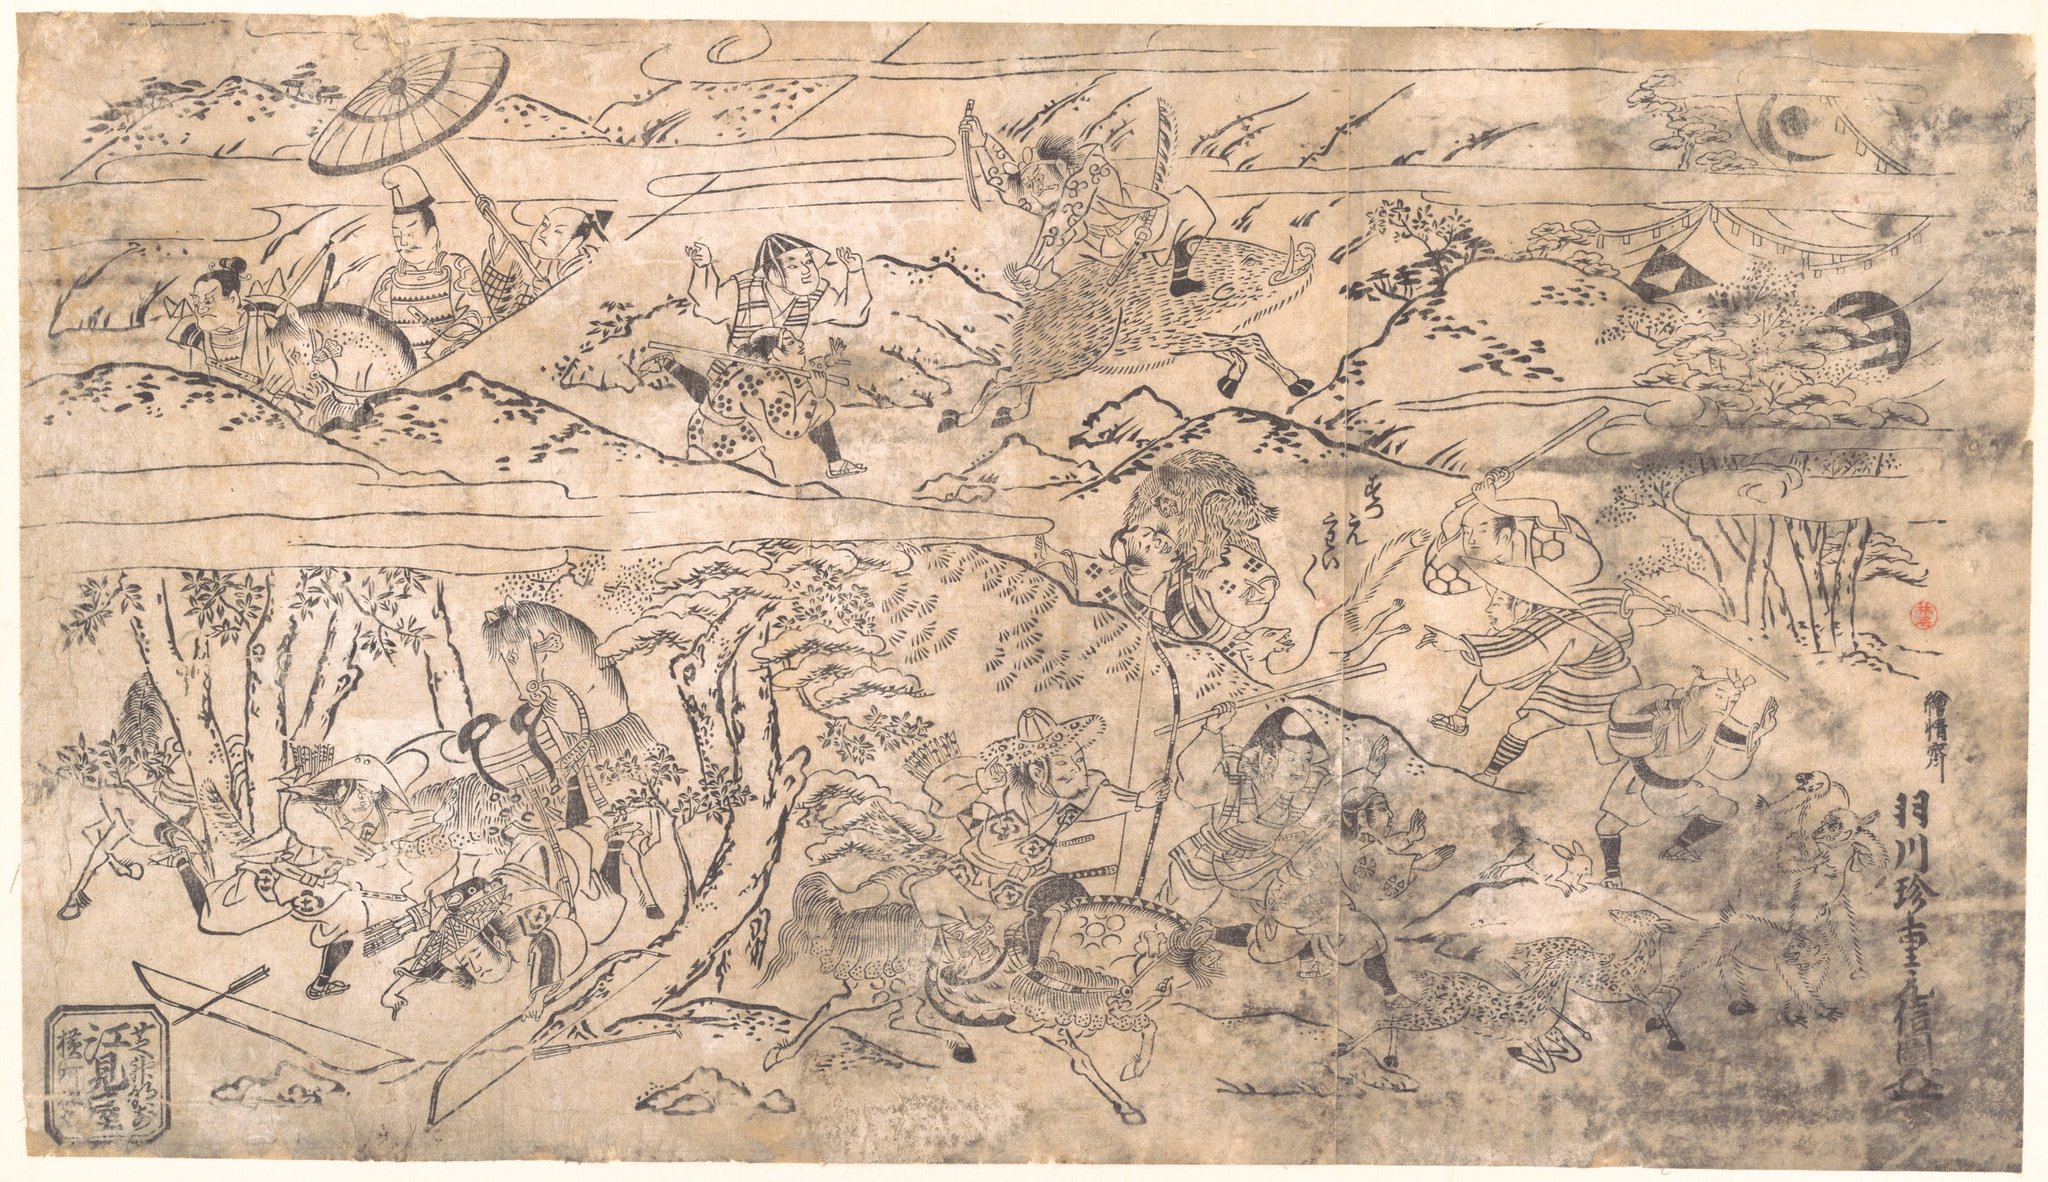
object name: print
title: Battle Scene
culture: japanese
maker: hanekawa chinchō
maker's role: artist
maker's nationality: japanese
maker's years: 1679-1754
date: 1669-1754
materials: ink, paper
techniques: woodblock print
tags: animals,battles,army,weapons